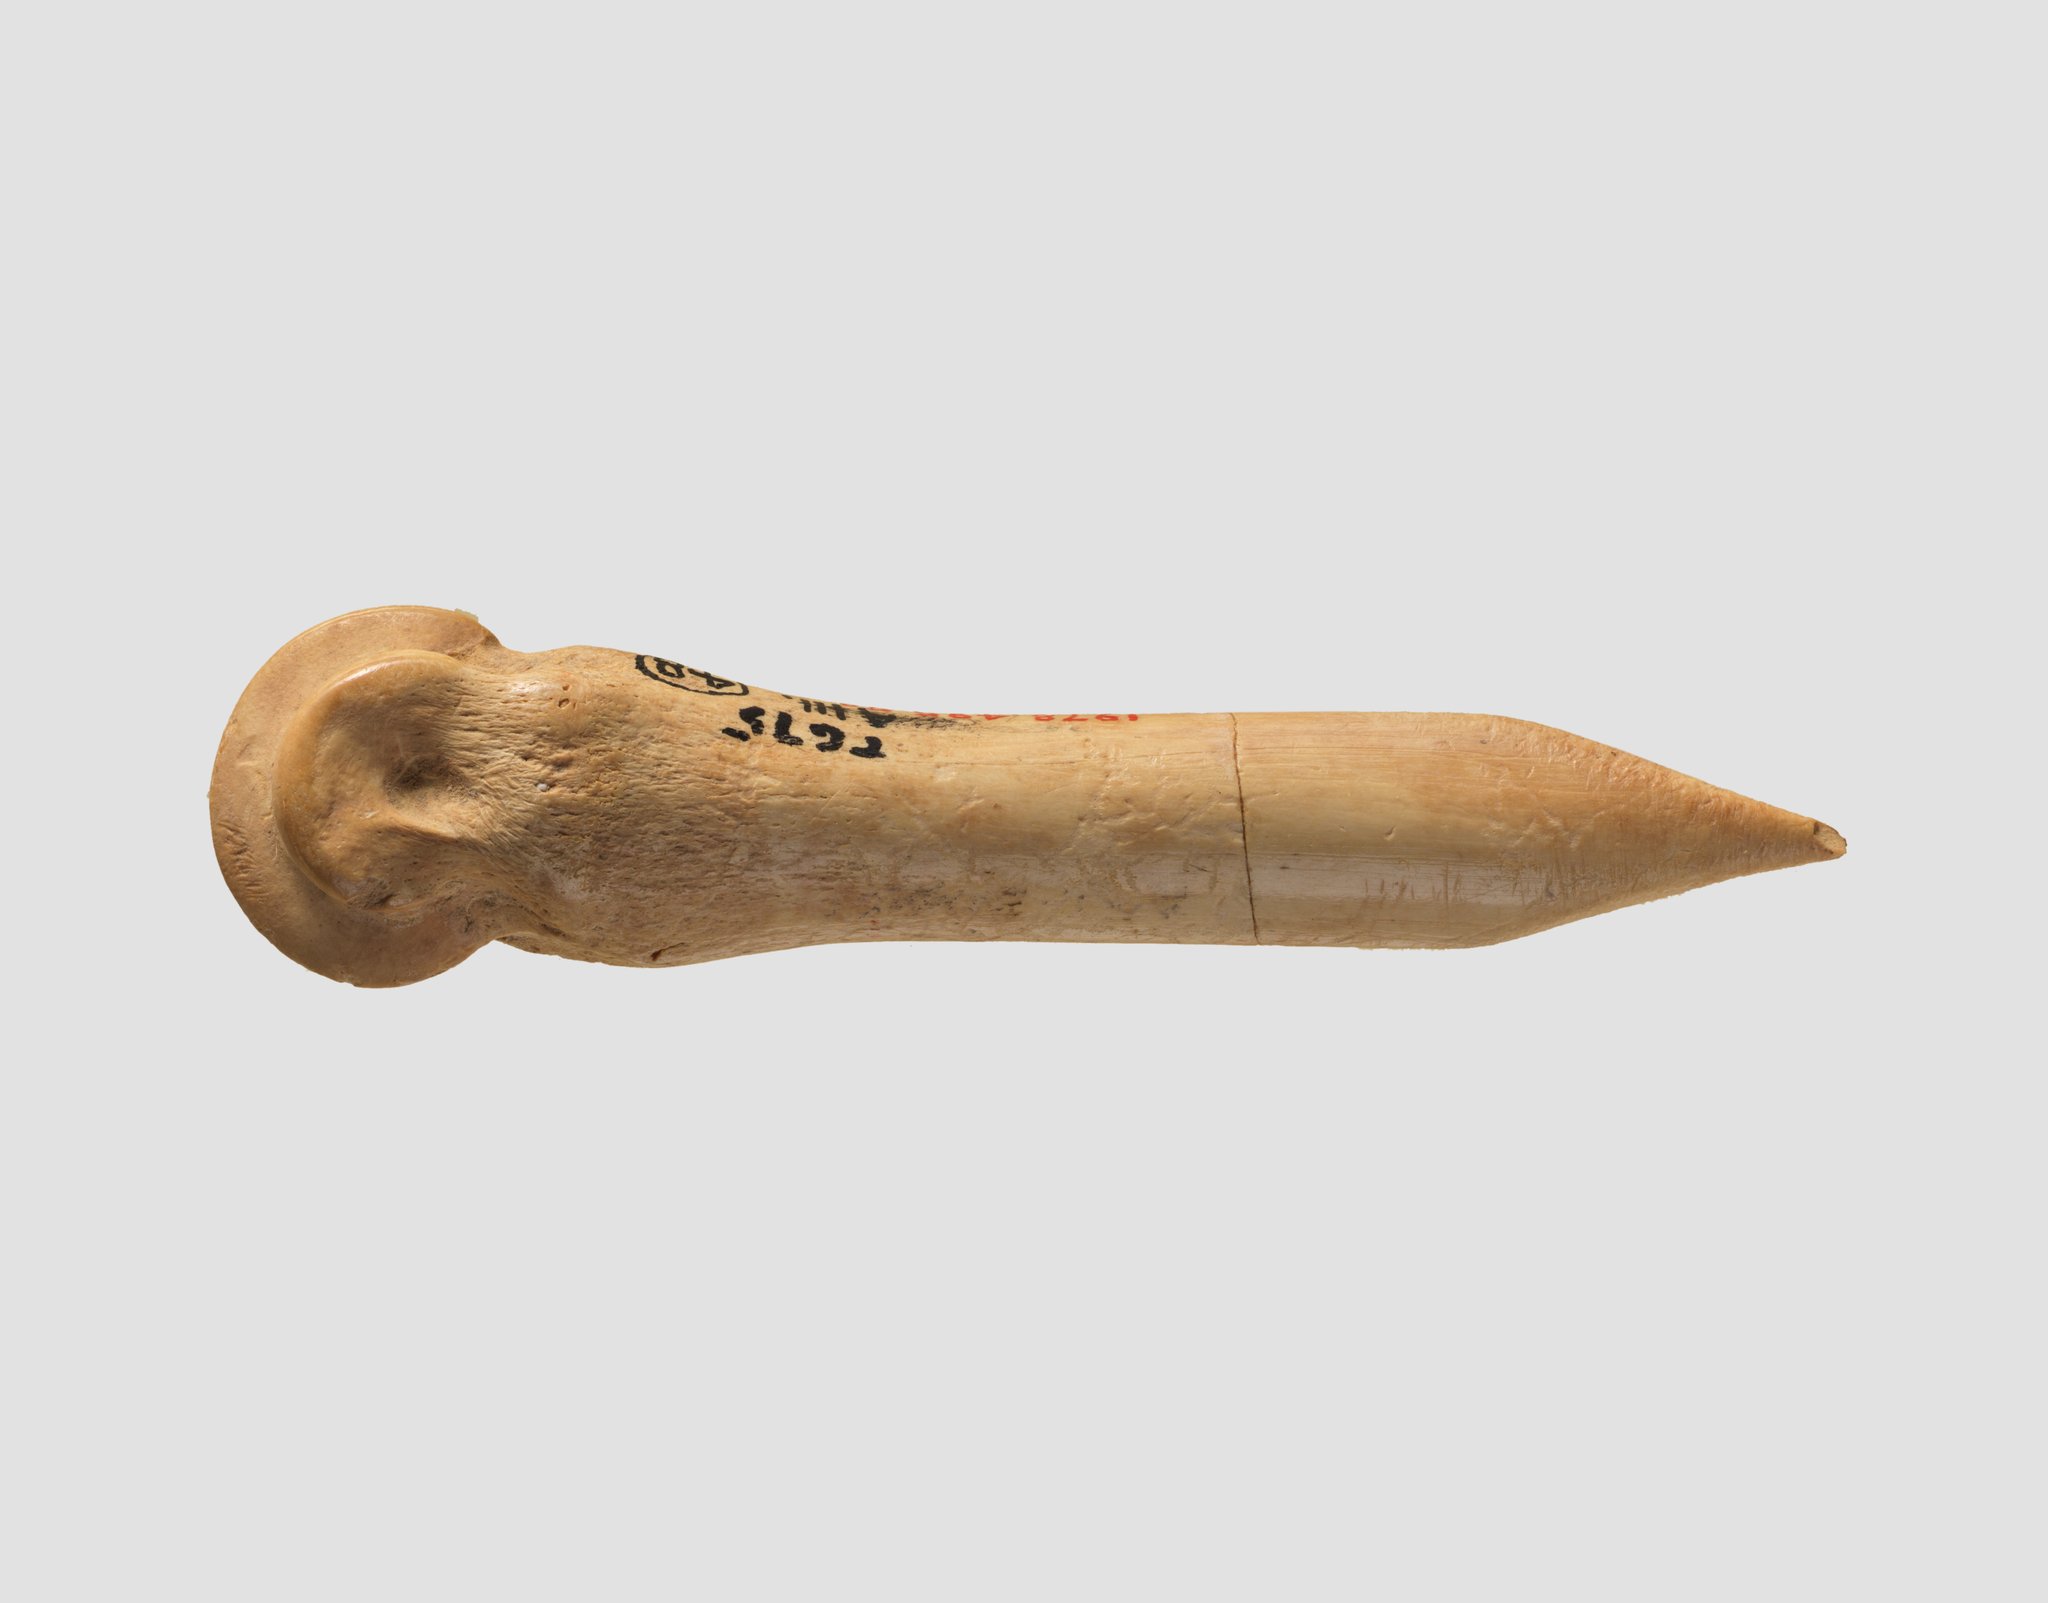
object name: awl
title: Awl (?)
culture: ghassulian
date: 4600-3600 BCE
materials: bone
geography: levant